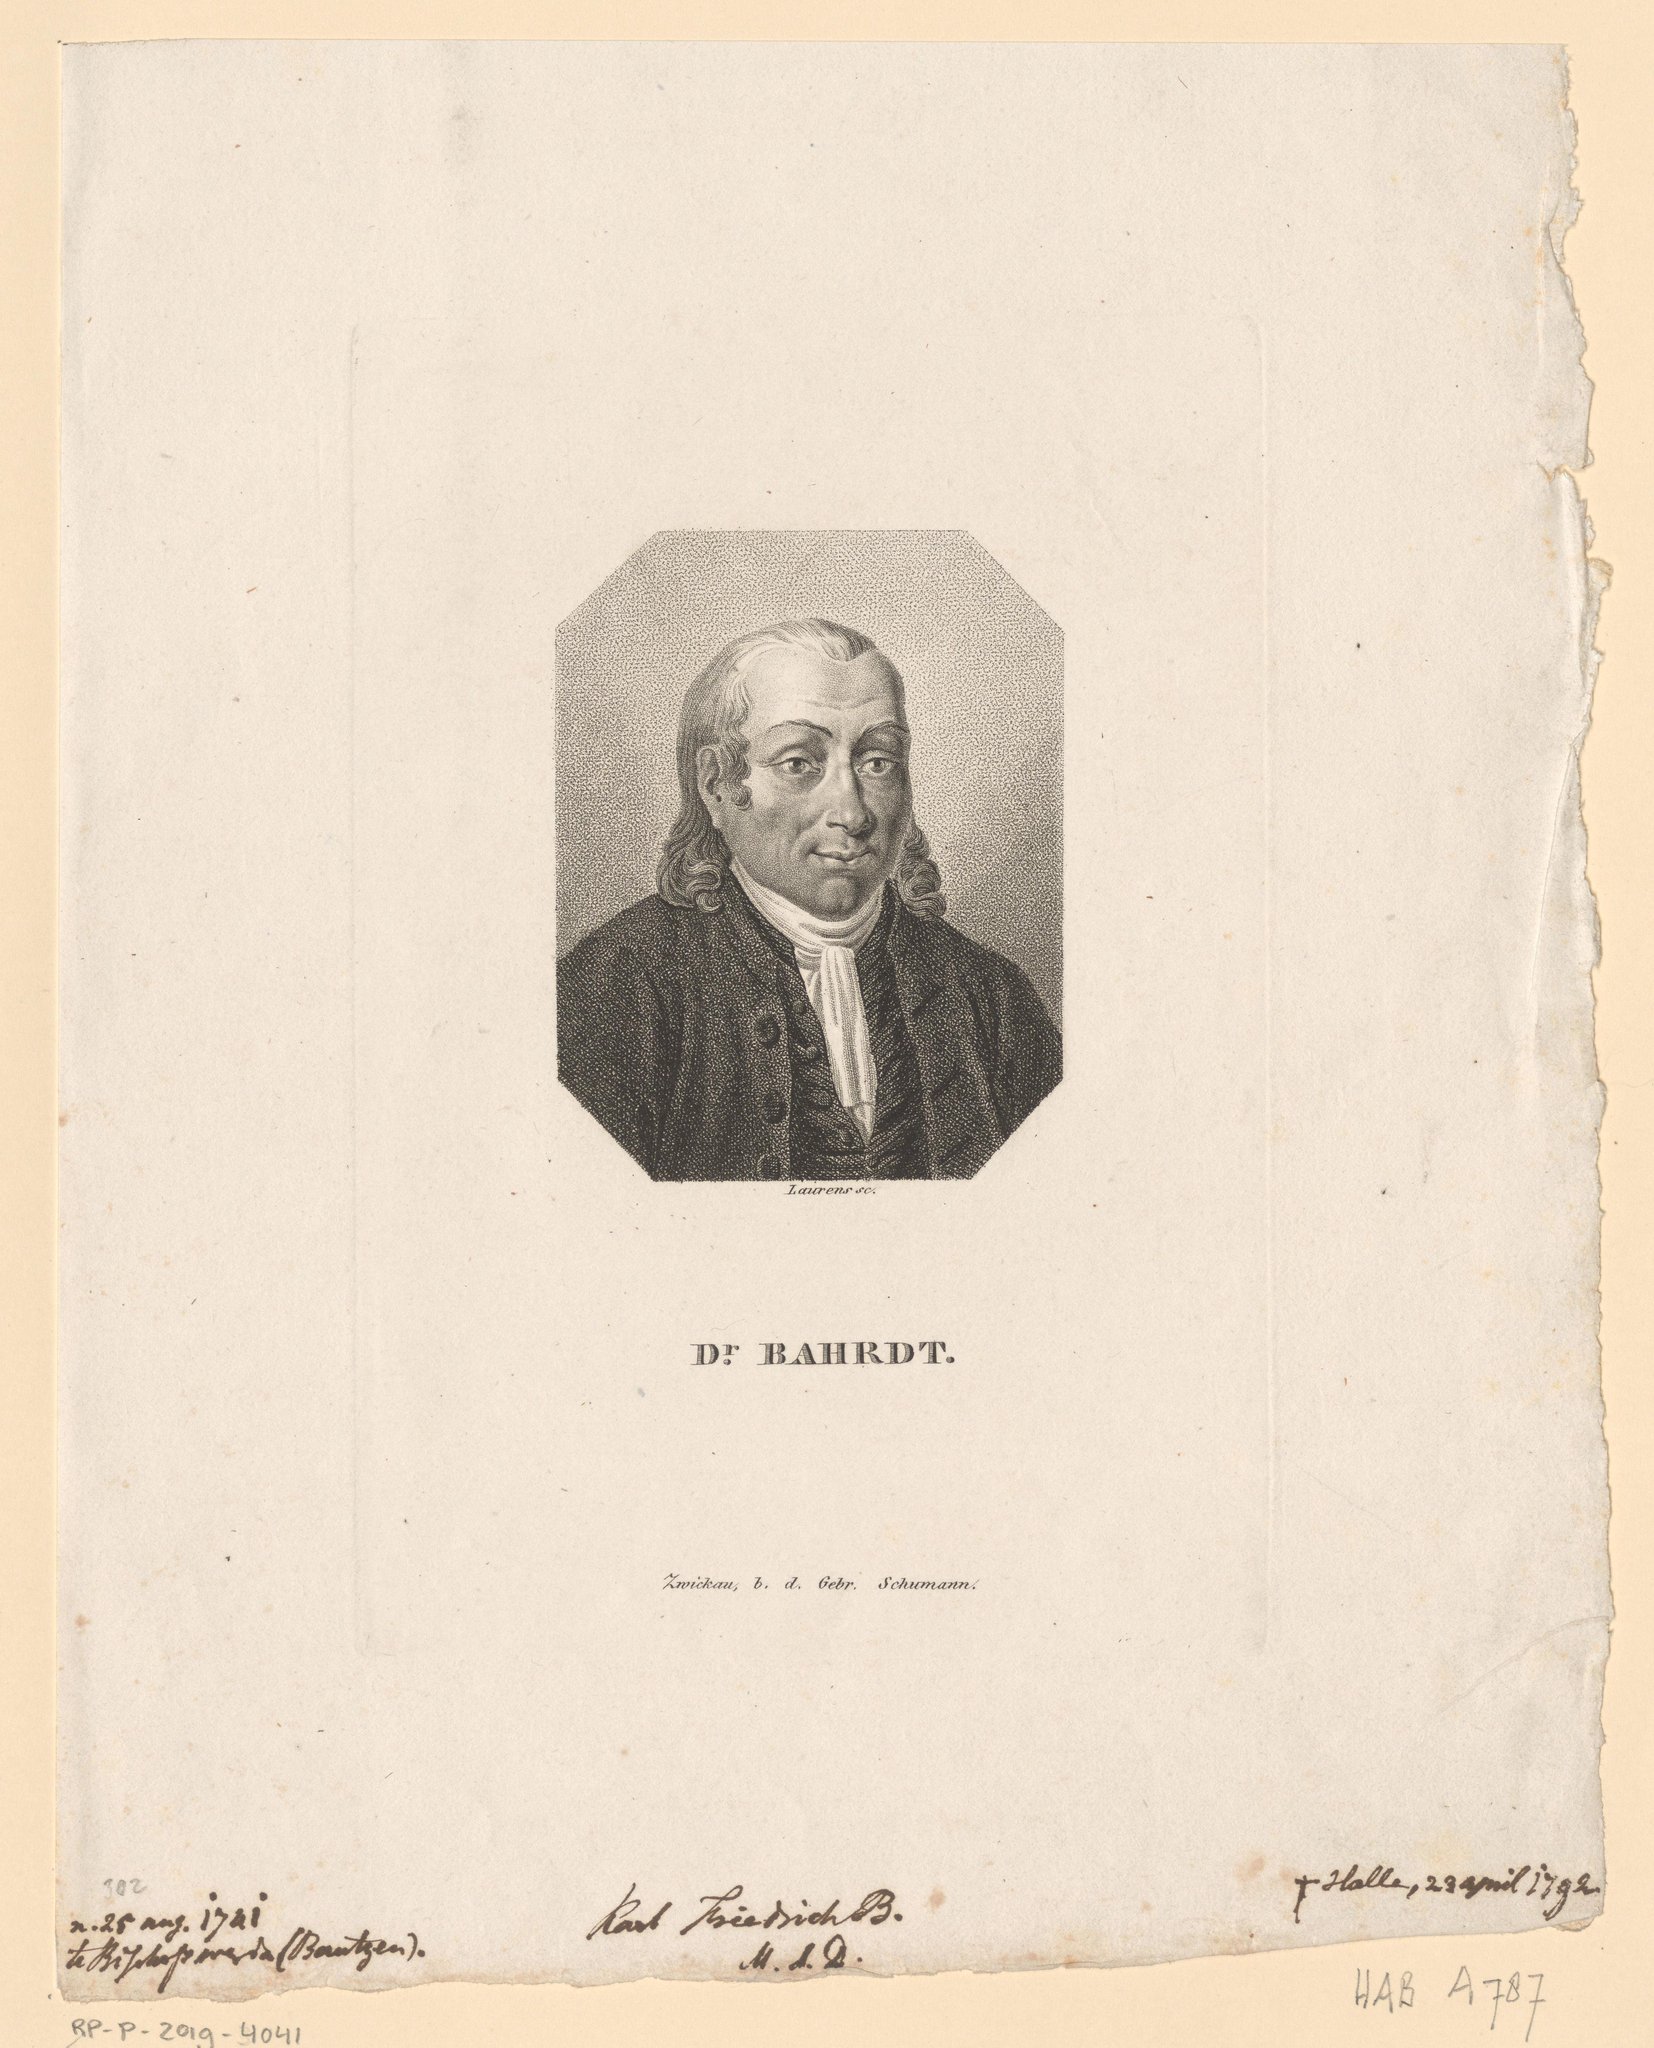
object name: print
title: Portretten van beroemde mensen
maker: johann daniel laurenz (ii)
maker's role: draughtsman, print maker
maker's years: 1770-1832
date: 1818-1832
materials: paper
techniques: etching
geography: zwickau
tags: historical persons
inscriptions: inscription: ‘n. 25 aug 1741 te Bischofswerda [...]’